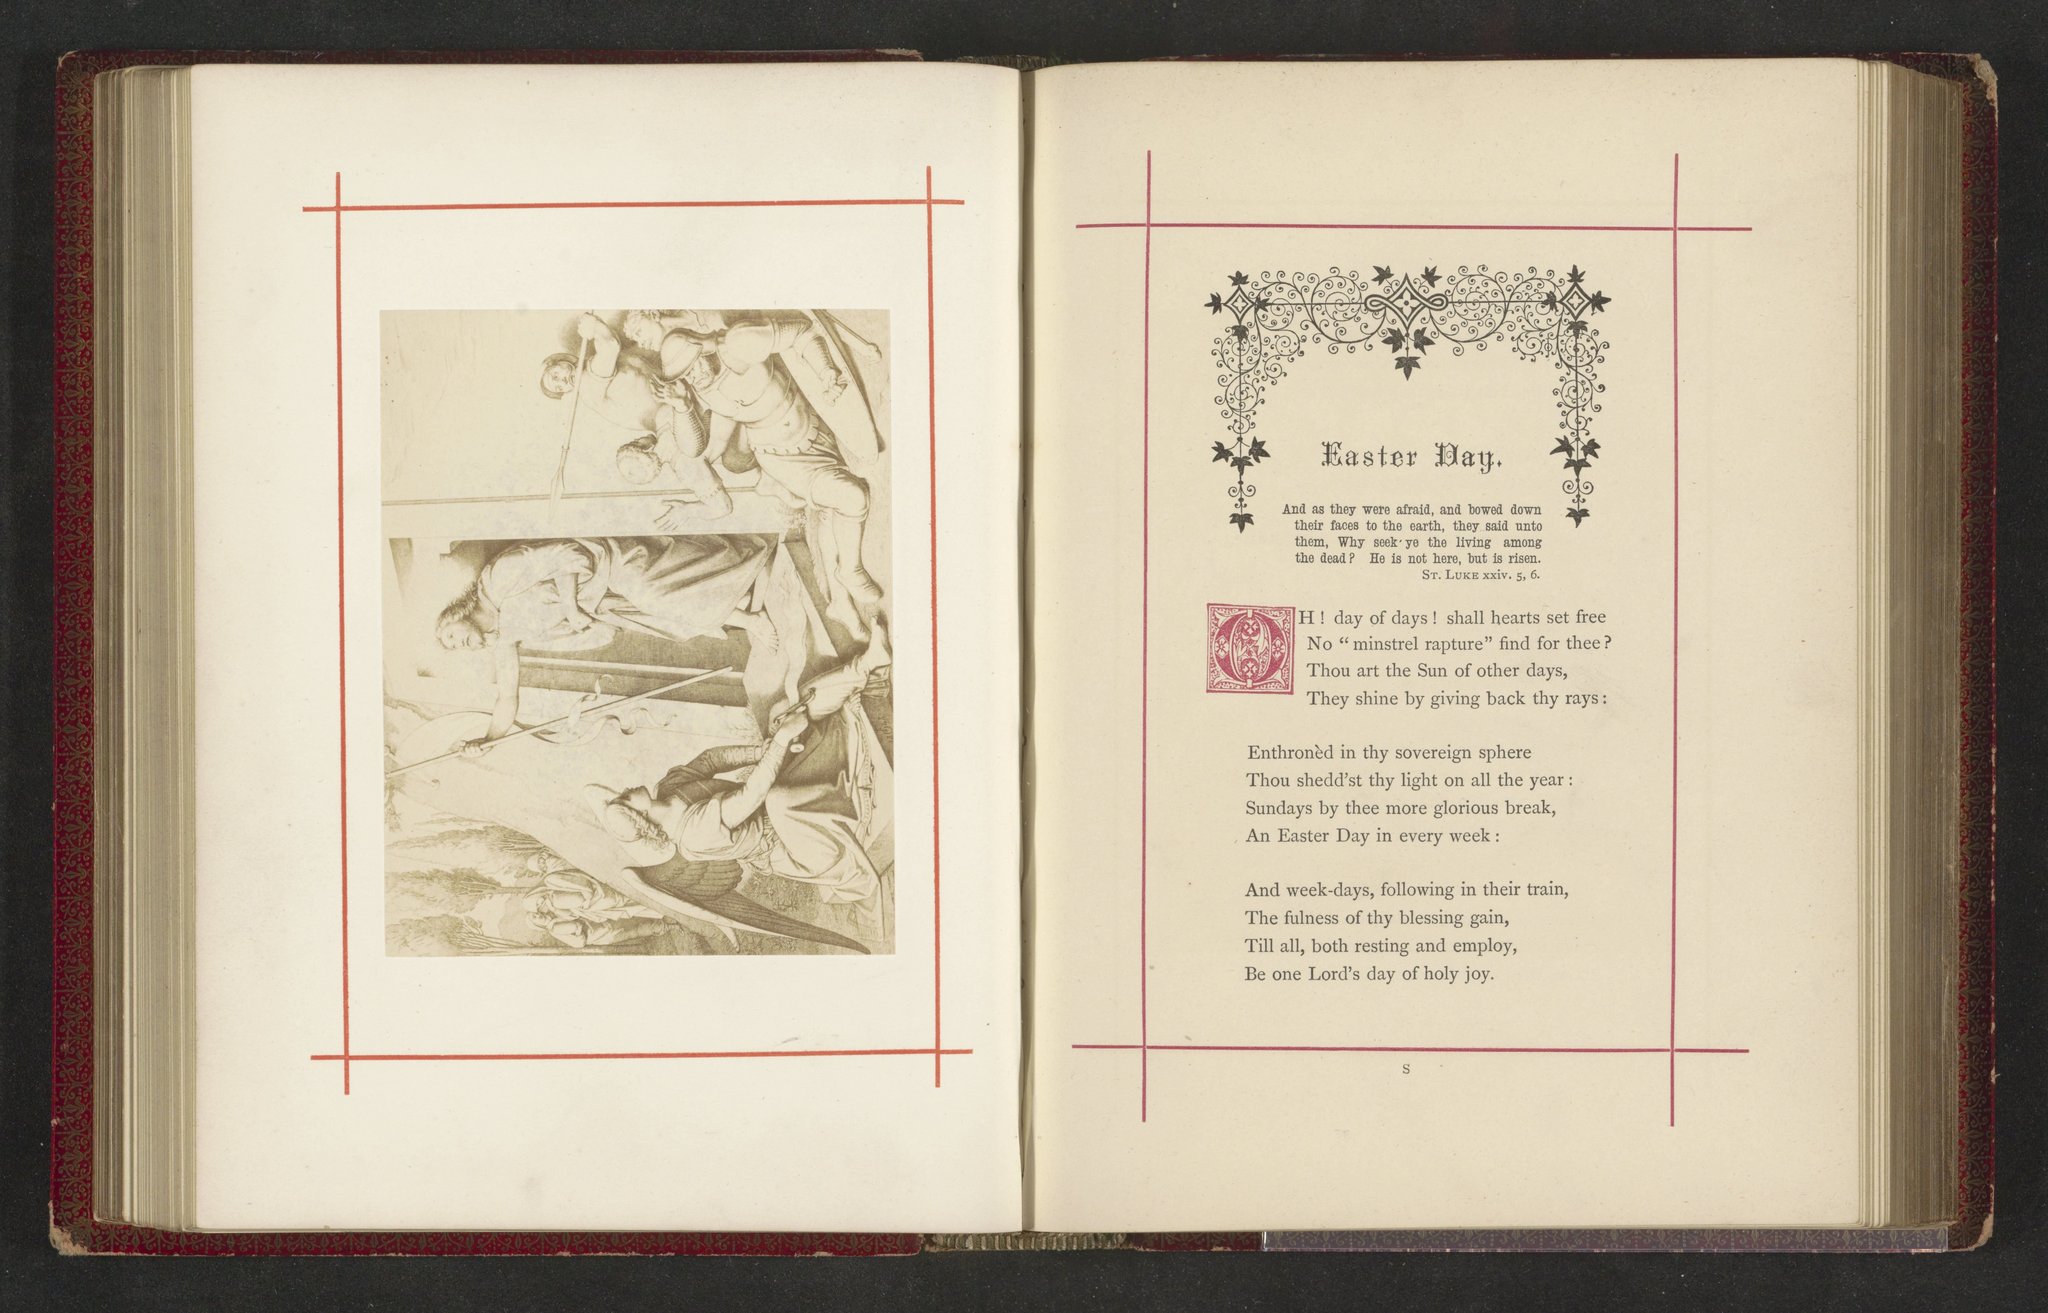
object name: page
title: Fotoreproductie van een prent, voorstellende de herrijzenis van Christus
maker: Anonymous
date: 1868-1873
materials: photographic support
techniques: albumen print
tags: christ, usually holding a banner, arises from the grave; often combined with sleeping and/or frightened soldiers